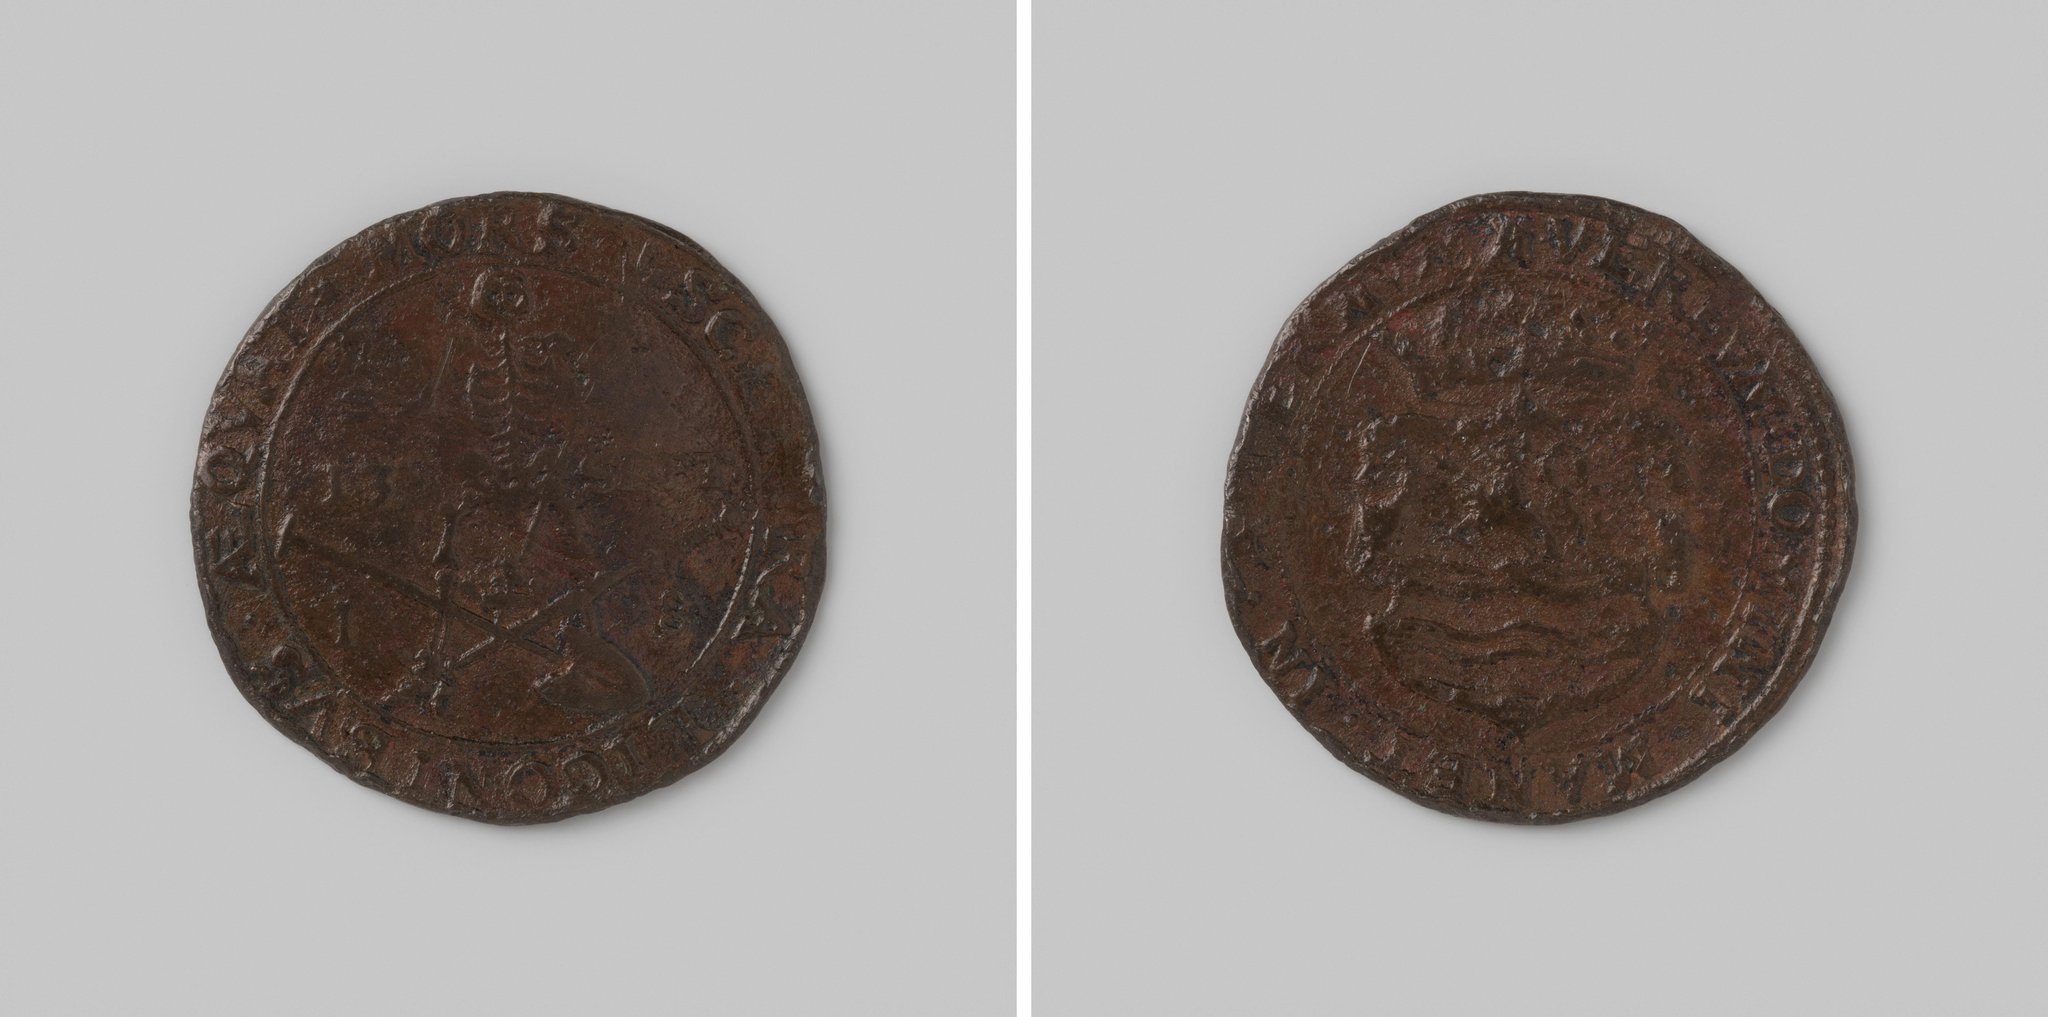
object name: jeton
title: Rekenpenning uit Middelburg op het overlijden van Philips II 1598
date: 1598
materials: copper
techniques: striking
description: Koperen penning, op de voorzijde de Dood staand op gekruiste spade en zwaard, met omschrift, op de keerzijde het gekroonde wapenschild van Zeeland, met omschrift.